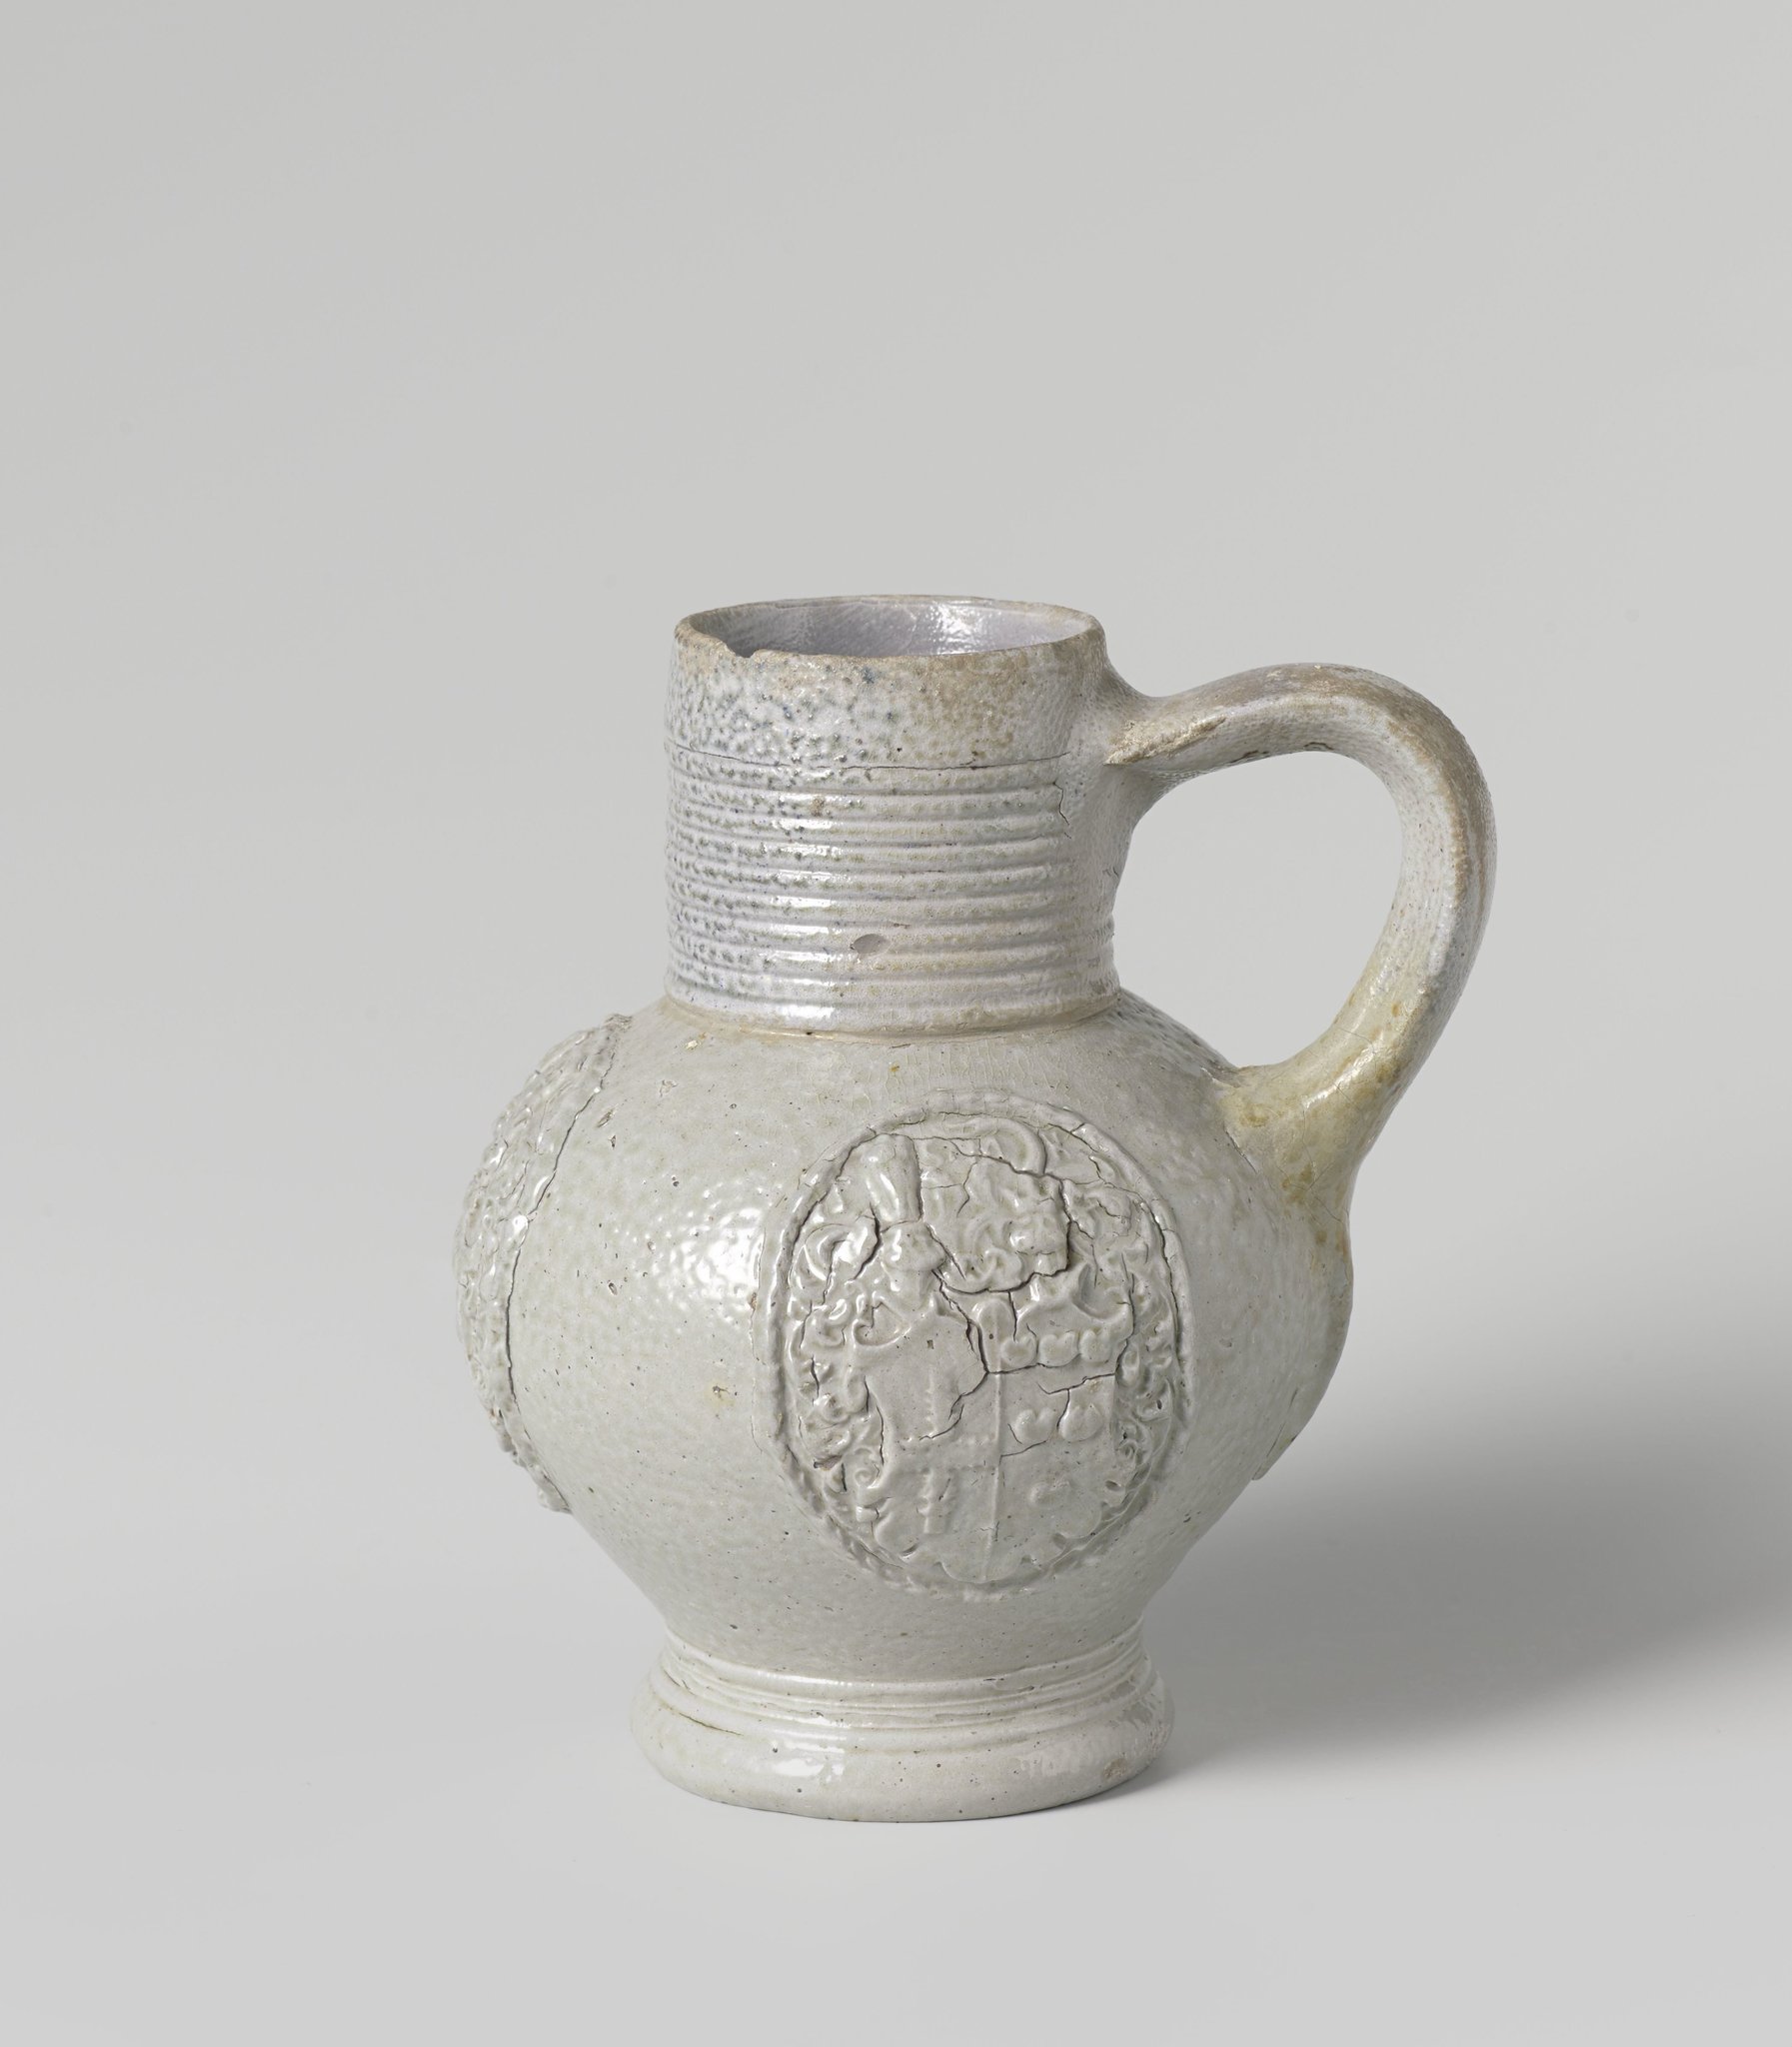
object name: jug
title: Jug with a coat of arms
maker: Anonymous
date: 1550-1599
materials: glaze, stoneware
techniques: firing, forming, relief, turning, vitrification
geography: raeren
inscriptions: inscription: ‘P S M K’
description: Kruik van steengoed op hoge voet met een bolvormig lichaam en wijde, geribde nek. Het C-vormige oor is bevestigd aan de nek en de schouder. Profielen op de voet. Op de buik in reliëf driemaal een gedrukt en opgelegd wapen (slecht zichtbaar) met het opschrift 'P S M K'. Raeren.